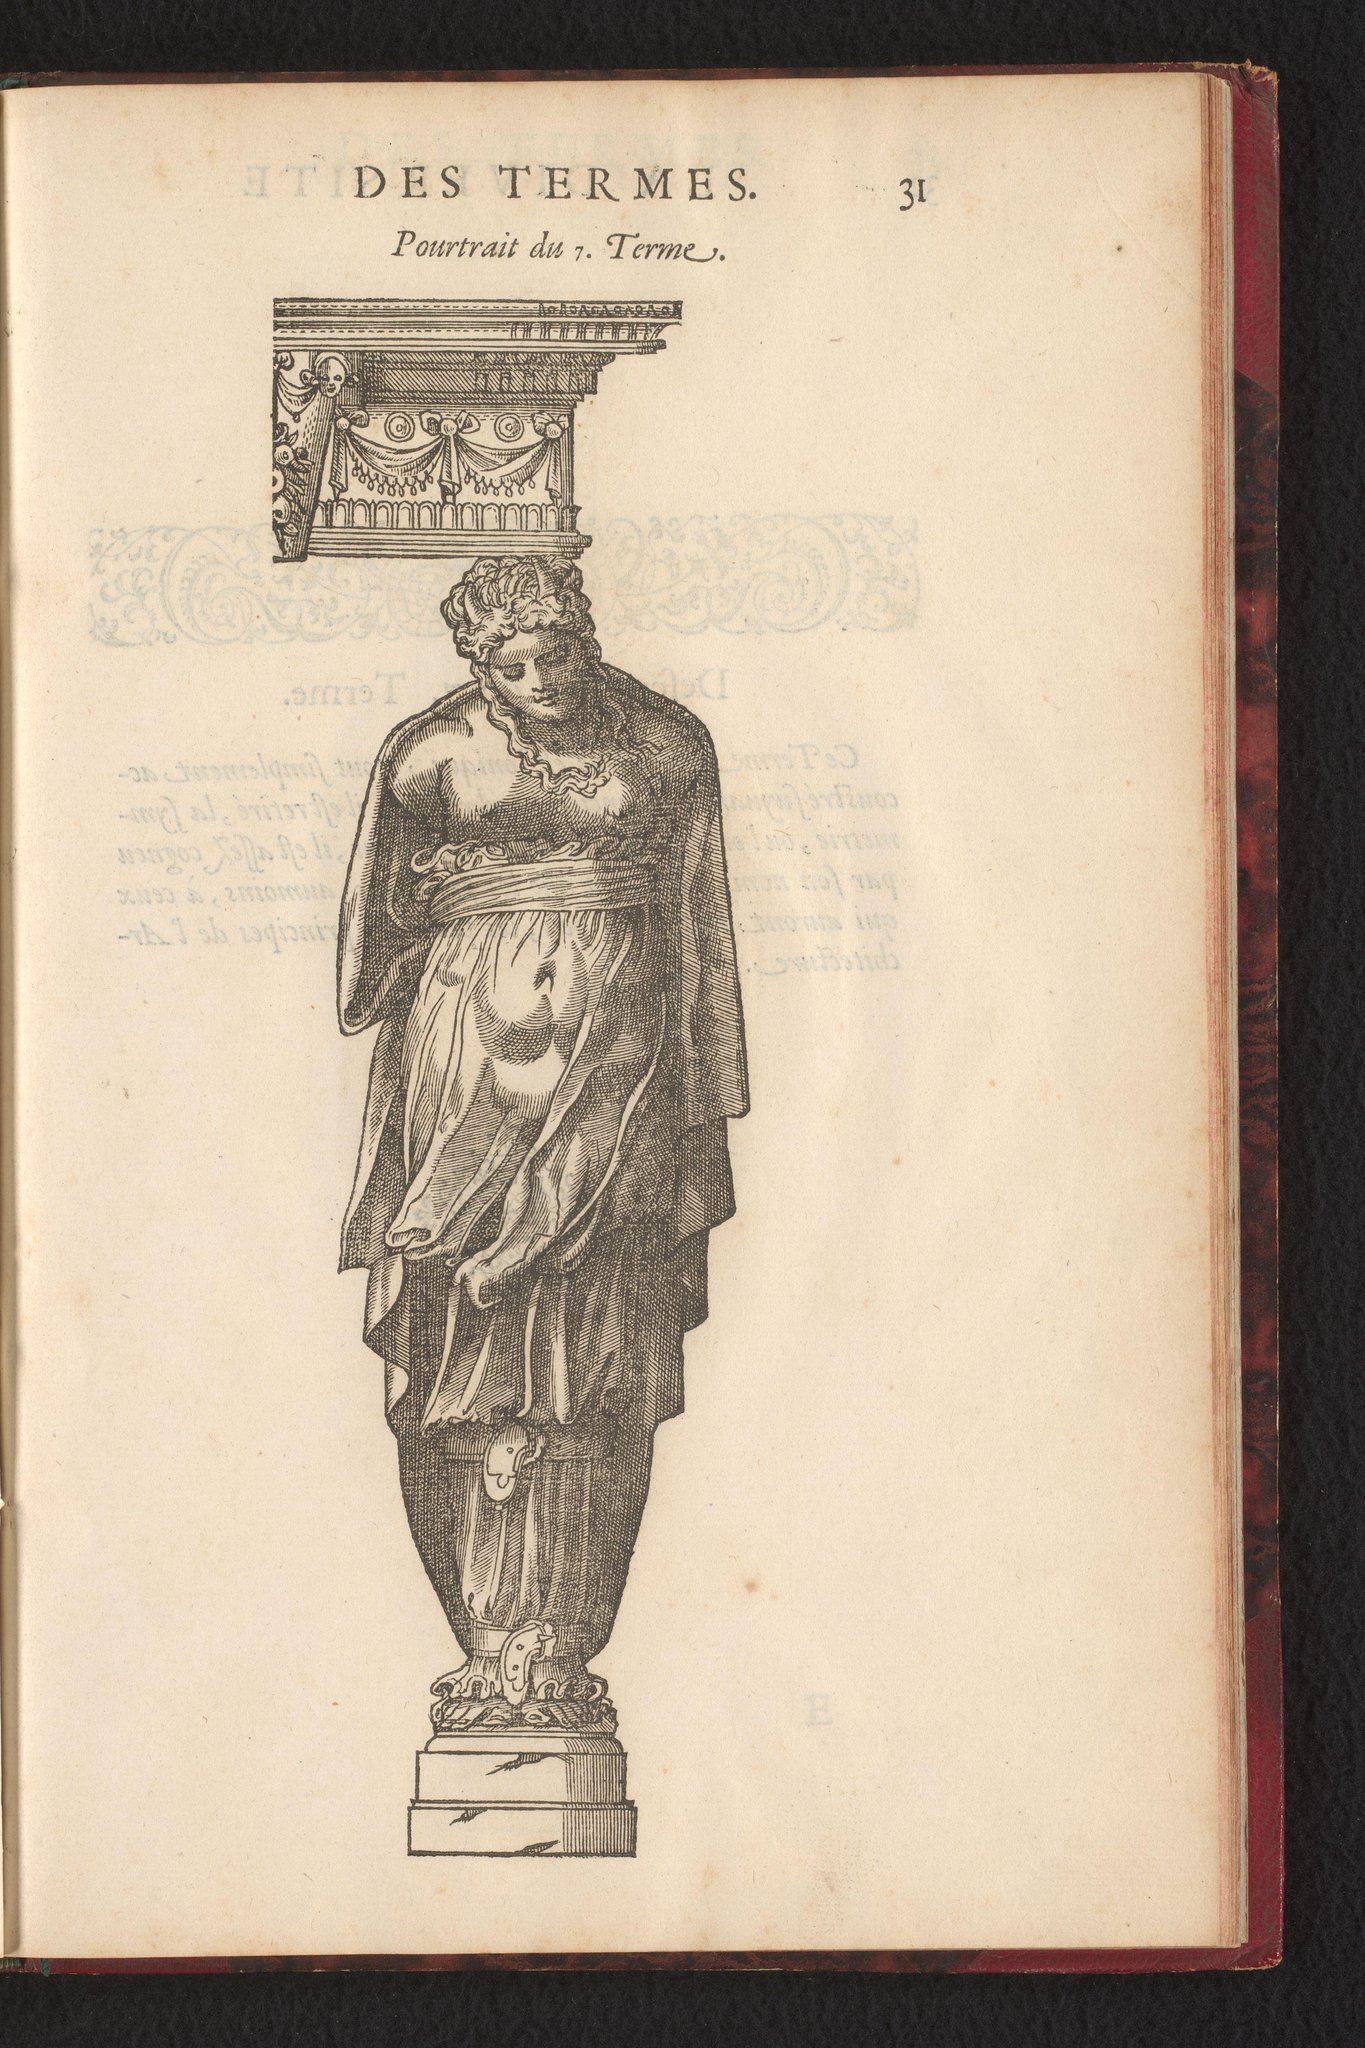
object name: print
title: Termen in verschillende architectonische orden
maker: Anonymous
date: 1572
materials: paper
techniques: letterpress printing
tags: herms (garden ornaments), satyr(s) (in general) - ll - female satyrs (in general), pedestal of a piece of sculpture (perhaps in the form of a herm), herm: pillar with the head of mercury, patron of travellers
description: Rechtsboven genummerd: 31. Volgens de toelichting op pagina 32 gaat het hier om de Ionische orde. Prent maakt deel uit van een album.